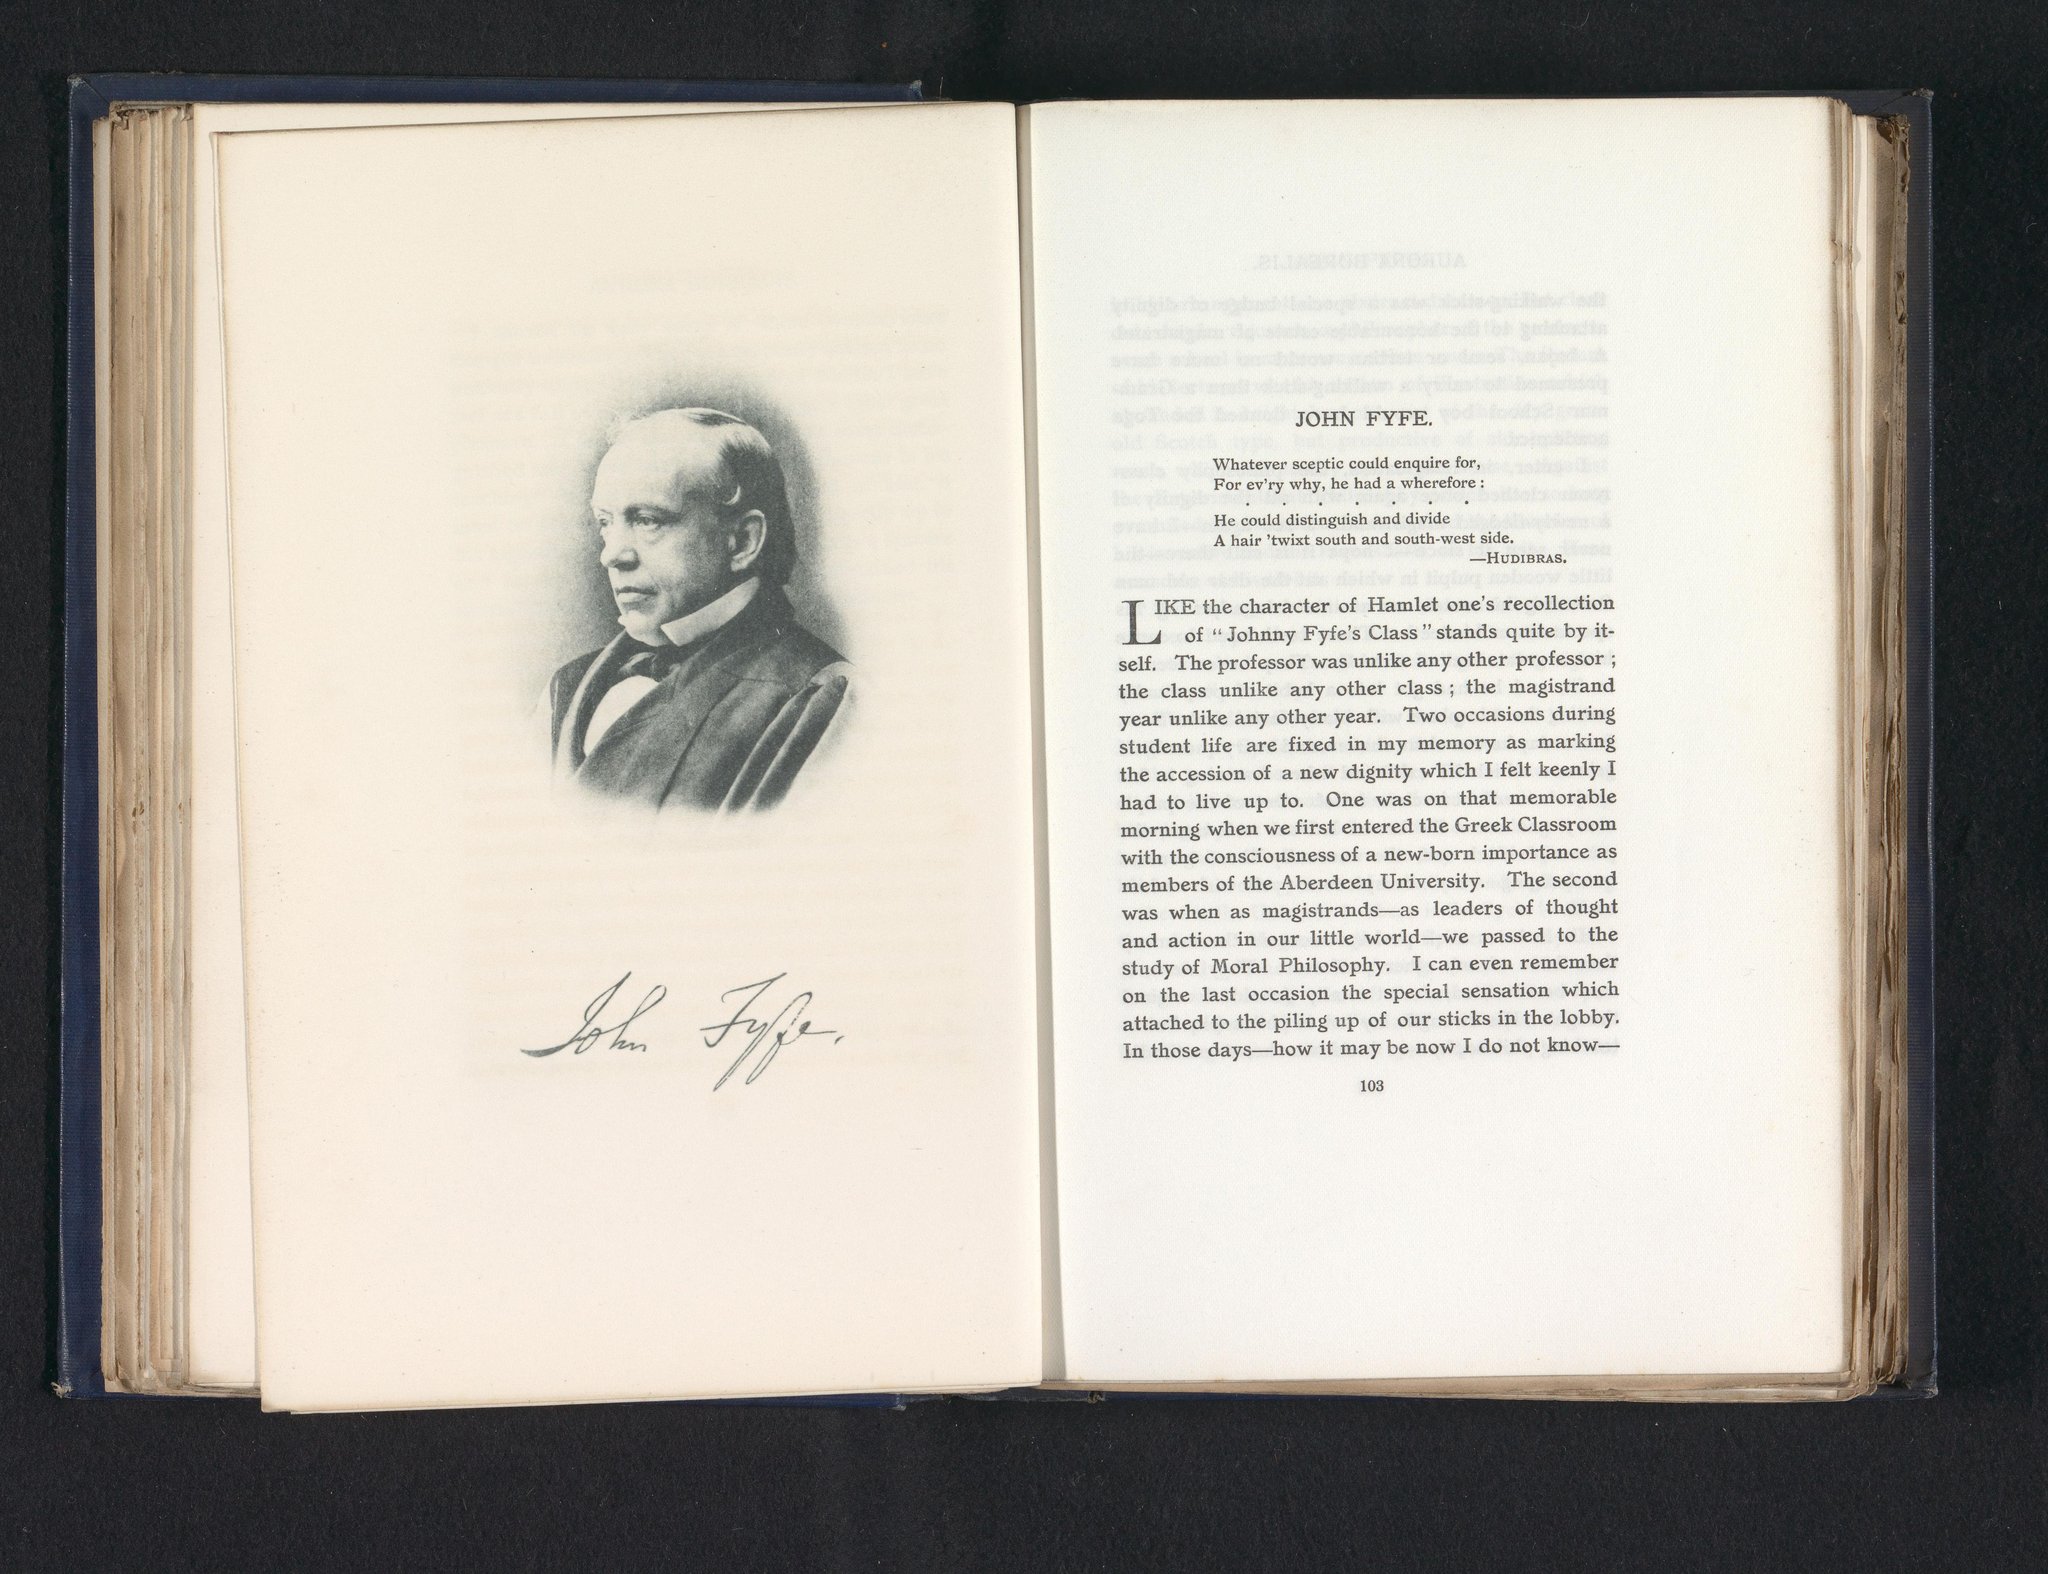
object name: photomechanical print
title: John Fyfe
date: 1889-1899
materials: paper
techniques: photograph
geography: aberdeen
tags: scholar, philosopher